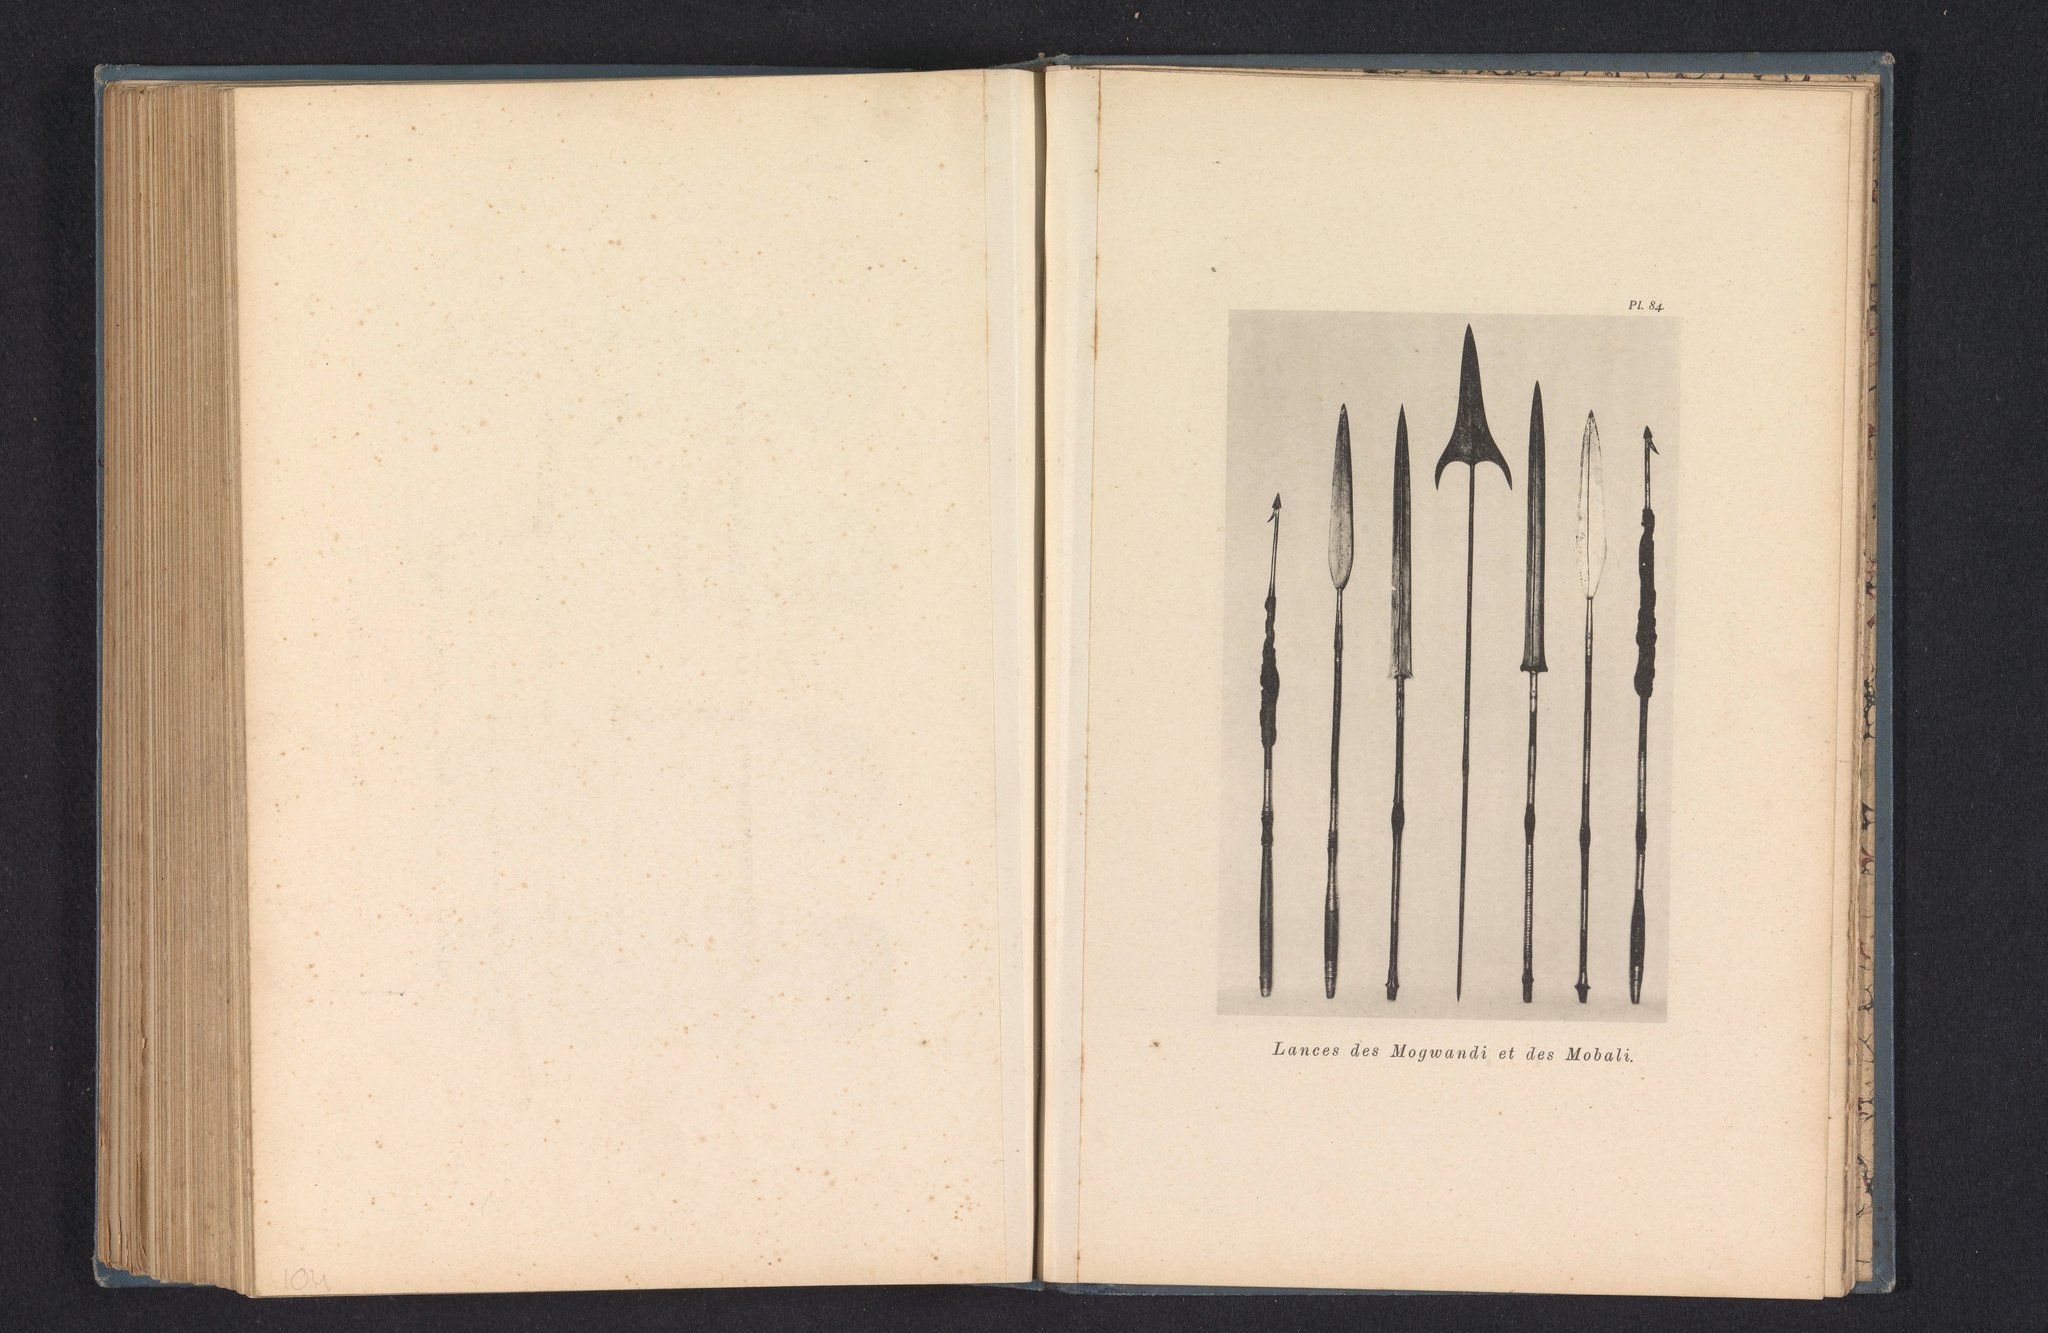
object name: page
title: Zeven speren van de Ngbandi en de Mobali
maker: franz thonner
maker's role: botanicus, ontdekkingsreiziger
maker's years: 1863-1928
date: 1896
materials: paper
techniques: photograph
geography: dresden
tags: casting weapons: spear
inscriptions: number: ‘Pl. 84.’